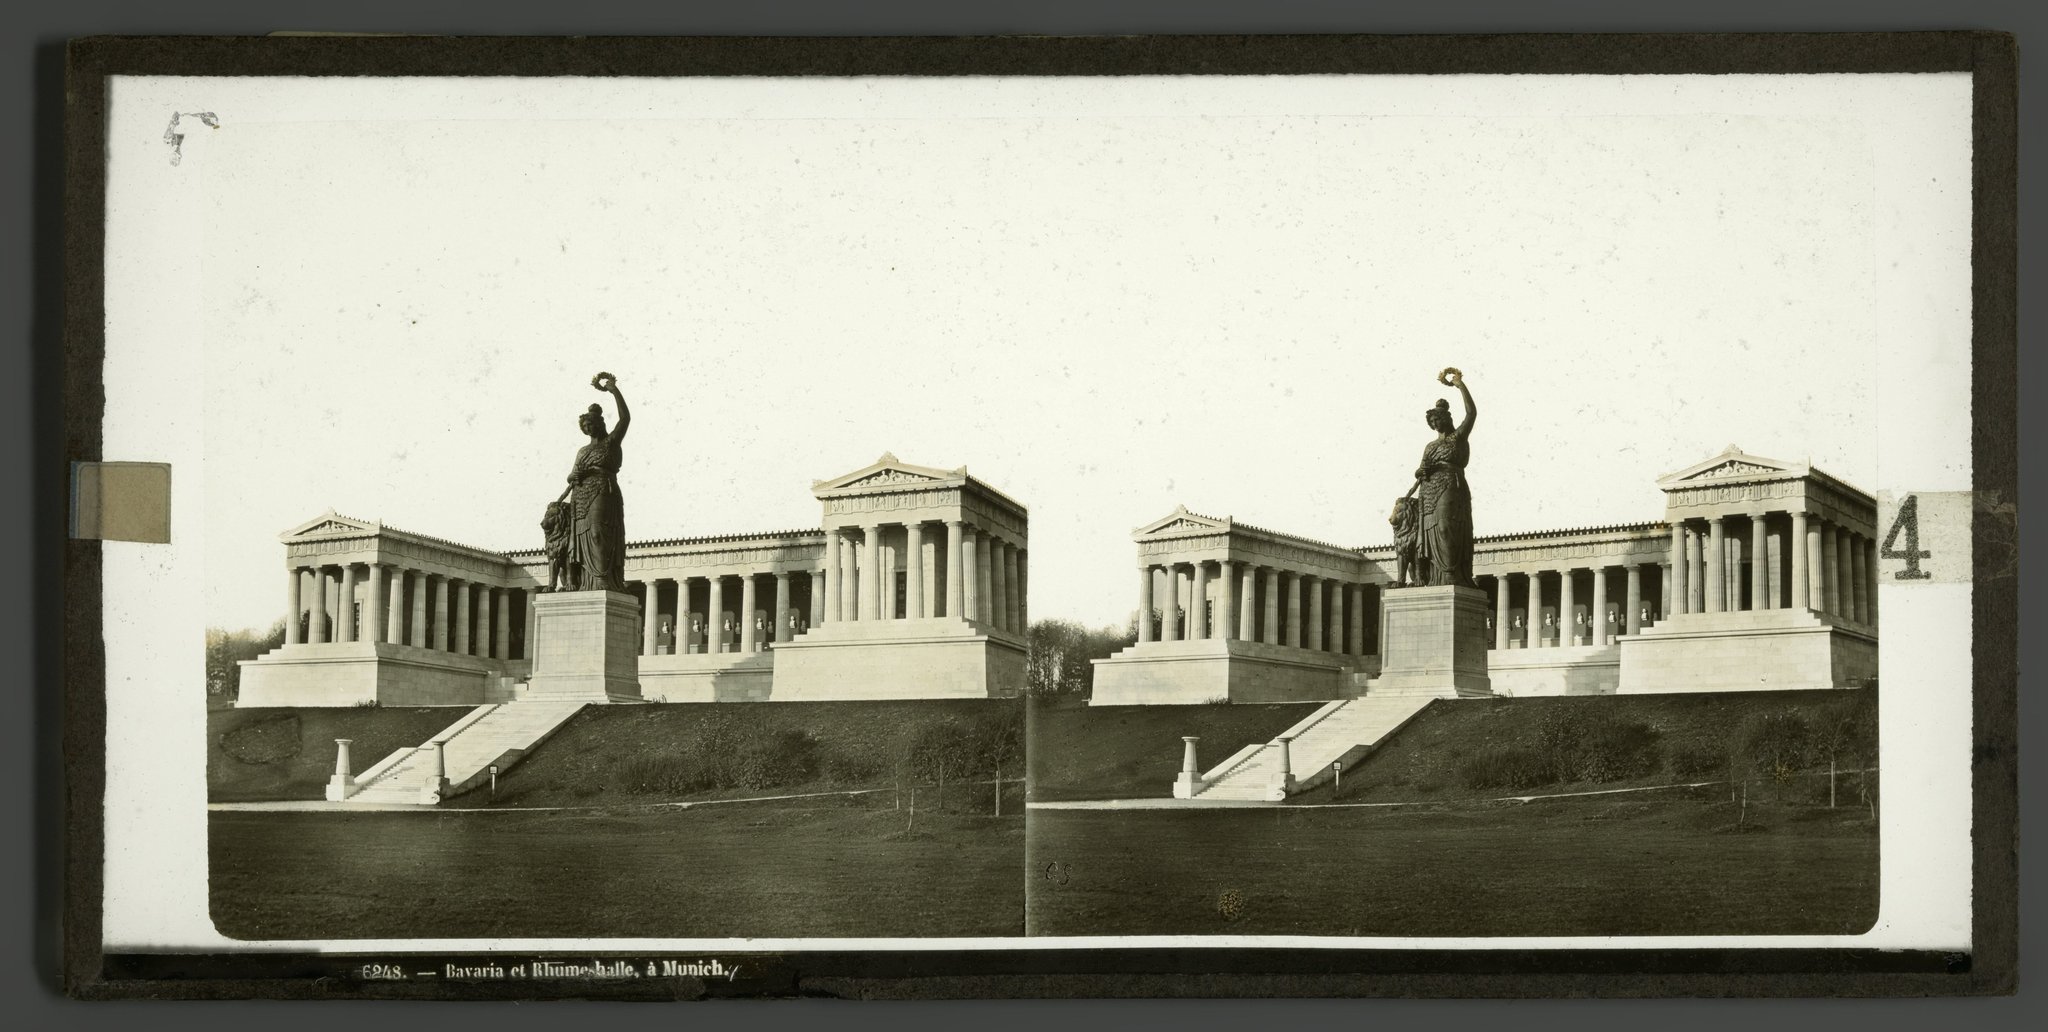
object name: photograph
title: Bavaria et Rhumeshalle, à Munich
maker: ferrier père-fils et soulier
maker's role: publisher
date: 1860-1890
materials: glass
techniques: slide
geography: munich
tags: palace, monument, statue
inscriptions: number: ‘6248.’